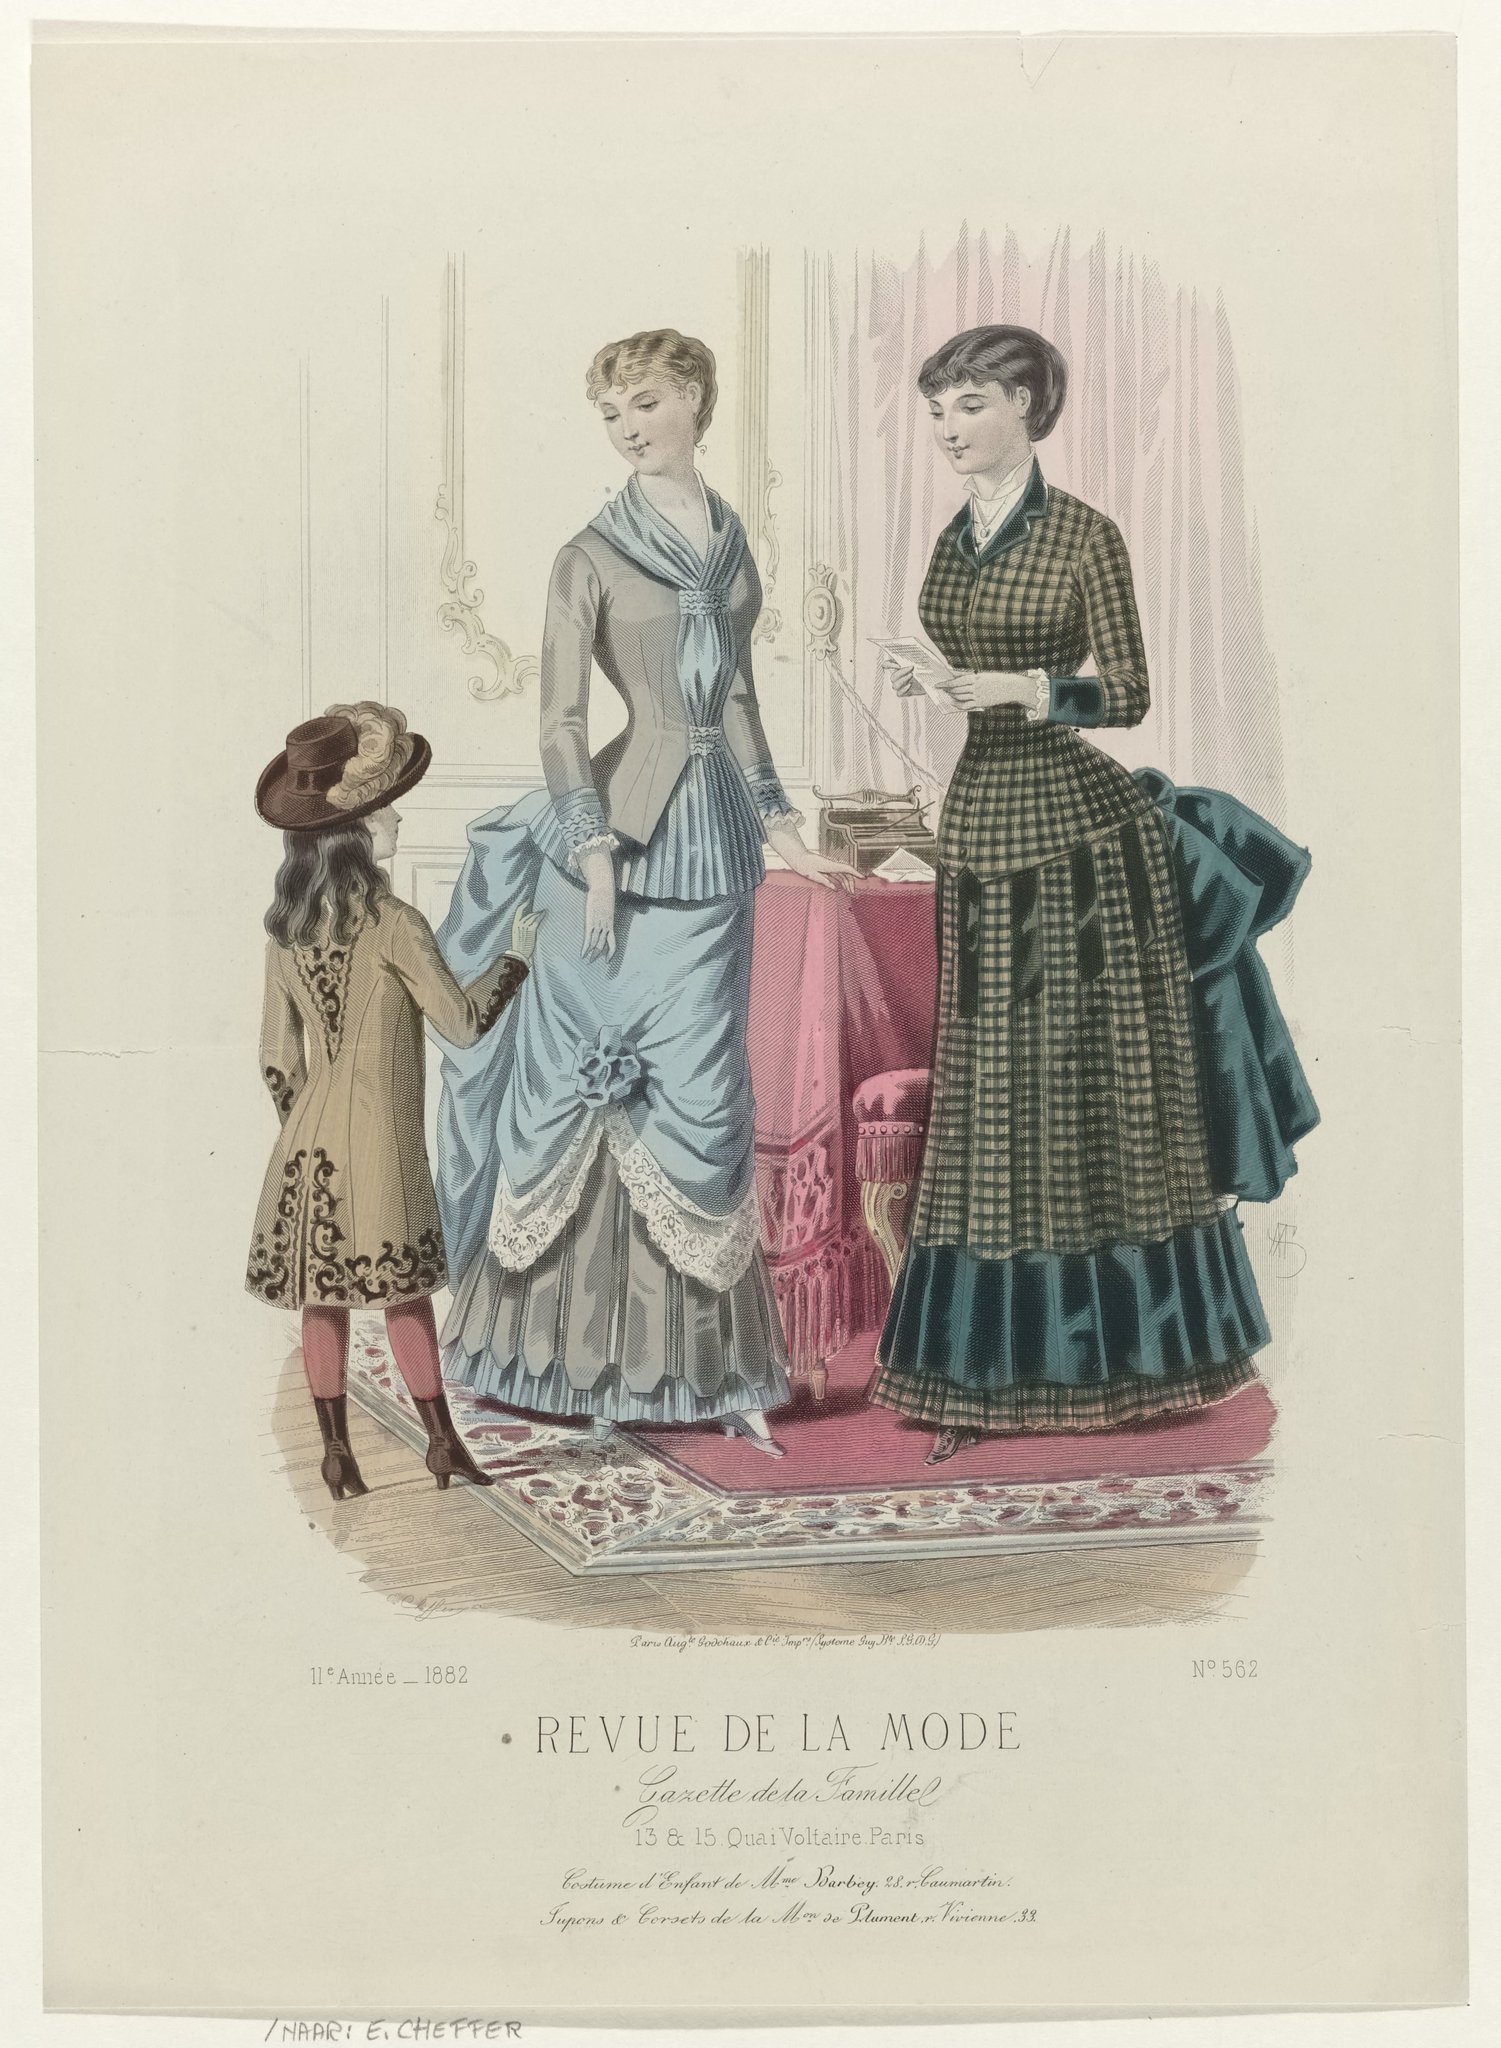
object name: fashion print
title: Revue de la Mode, Gazette de la Famille, dimanche 8 octobre 1882, 11e année, No. 562: Costume d'Enfant (...)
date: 1882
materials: paper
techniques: engraving, hand coloring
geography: paris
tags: neck-gear ~ clothing (revers) (+ women's clothes), embroidery (ornamentation) (+ women's clothes), lace (+ women's clothes), head-gear: hat (+ girls' clothes), boots (+ girls' clothes), fashion plates, skirt (+ women's clothes), dress, gown (+ women's clothes), letter, envelope, dress, gown (+ girls' clothes)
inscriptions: title: ‘REVUE DE LA MODE / Gazette de la Famille’, caption: ‘Costume d'Enfant de M.me Barbey, 28.r. Caumartin. Jupons & Corsets de la M.on de Plument.r. Vivienne. 33.’, address: ‘13 & 15, Quai Voltaire, Paris’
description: Twee vrouwen, van wie één met brief in de handen, en een meisje, in een interieur. Links: 'toilette' van blauwe 'surah' en grijze zijde. Rechts: 'toilette' van groene Schots geruite wol en effen velours. De kinderkleding is van Barbey: 'toilette' voor een meisje van 10 jaar. Onder de afbeelding een regel reclametekst voor verschillende producten. Prent uit het modetijdschrift Revue de la Mode (1872-1913). Uitgebreide beschrijving van de kleding op pagina 331 "PLANCHE COLORIÉE".